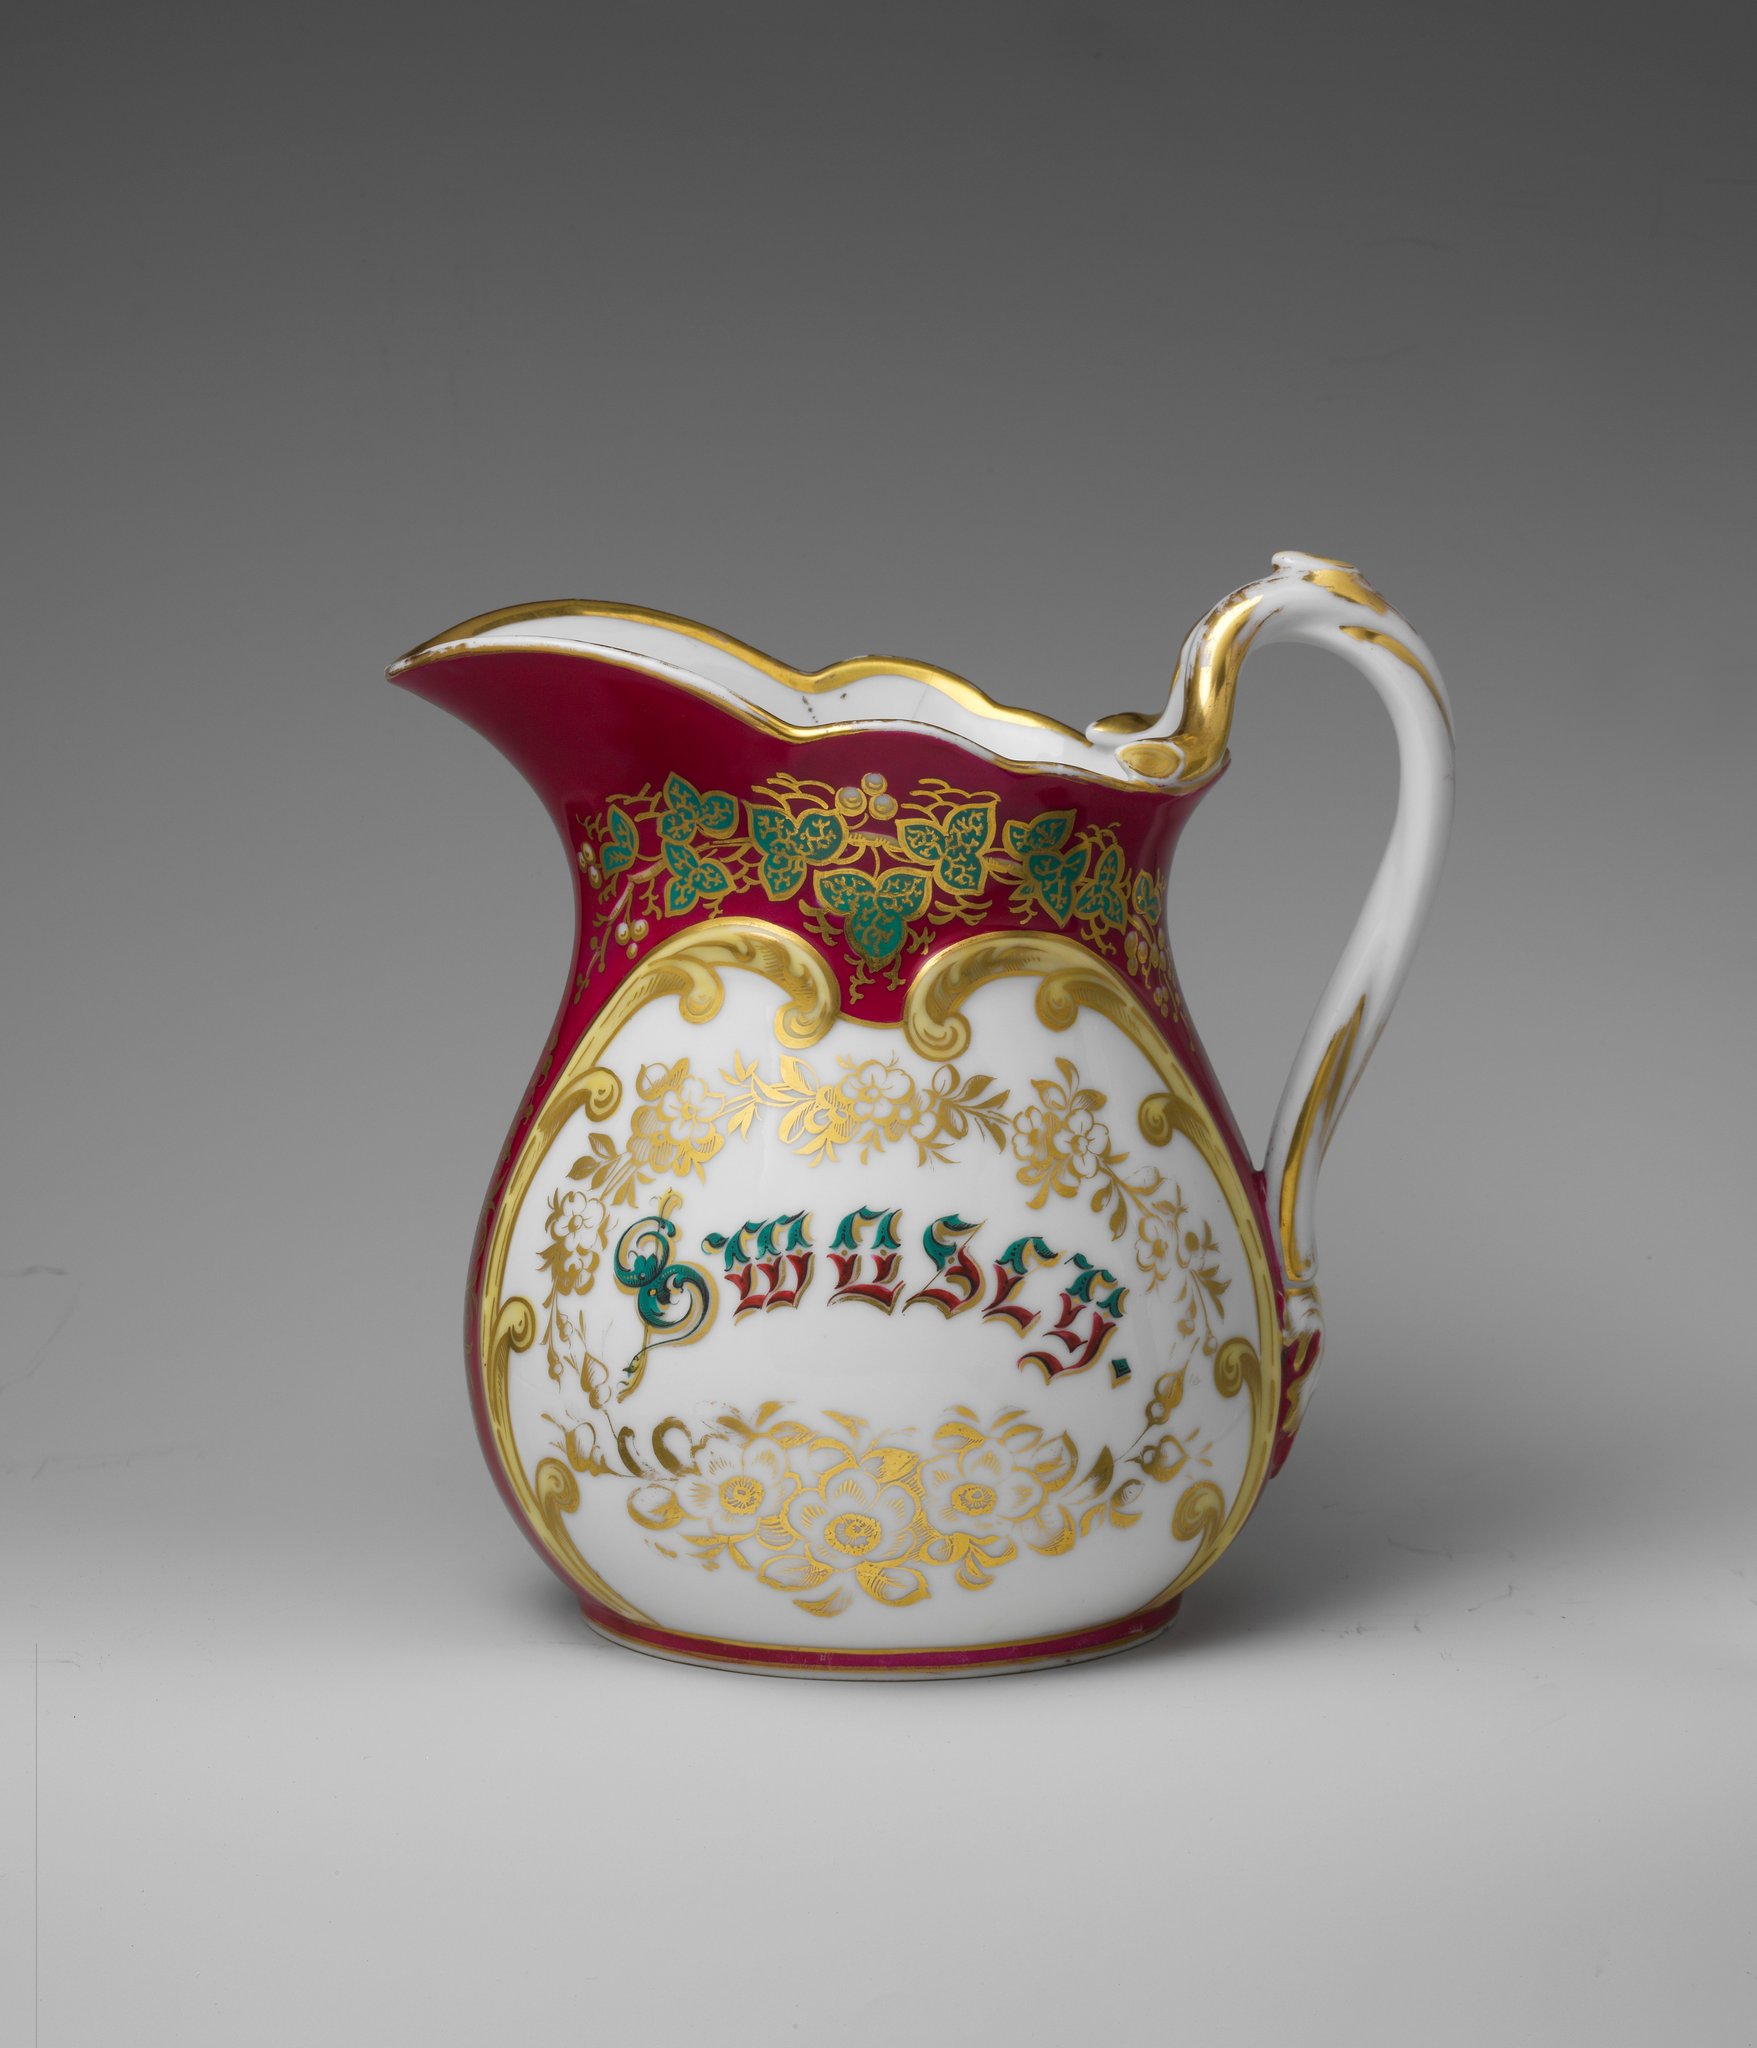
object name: pitcher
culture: american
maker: boston china decorating works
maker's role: decorator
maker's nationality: american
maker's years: 1860-1925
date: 1865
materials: enamel, porcelain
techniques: gilding, overglaze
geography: united states